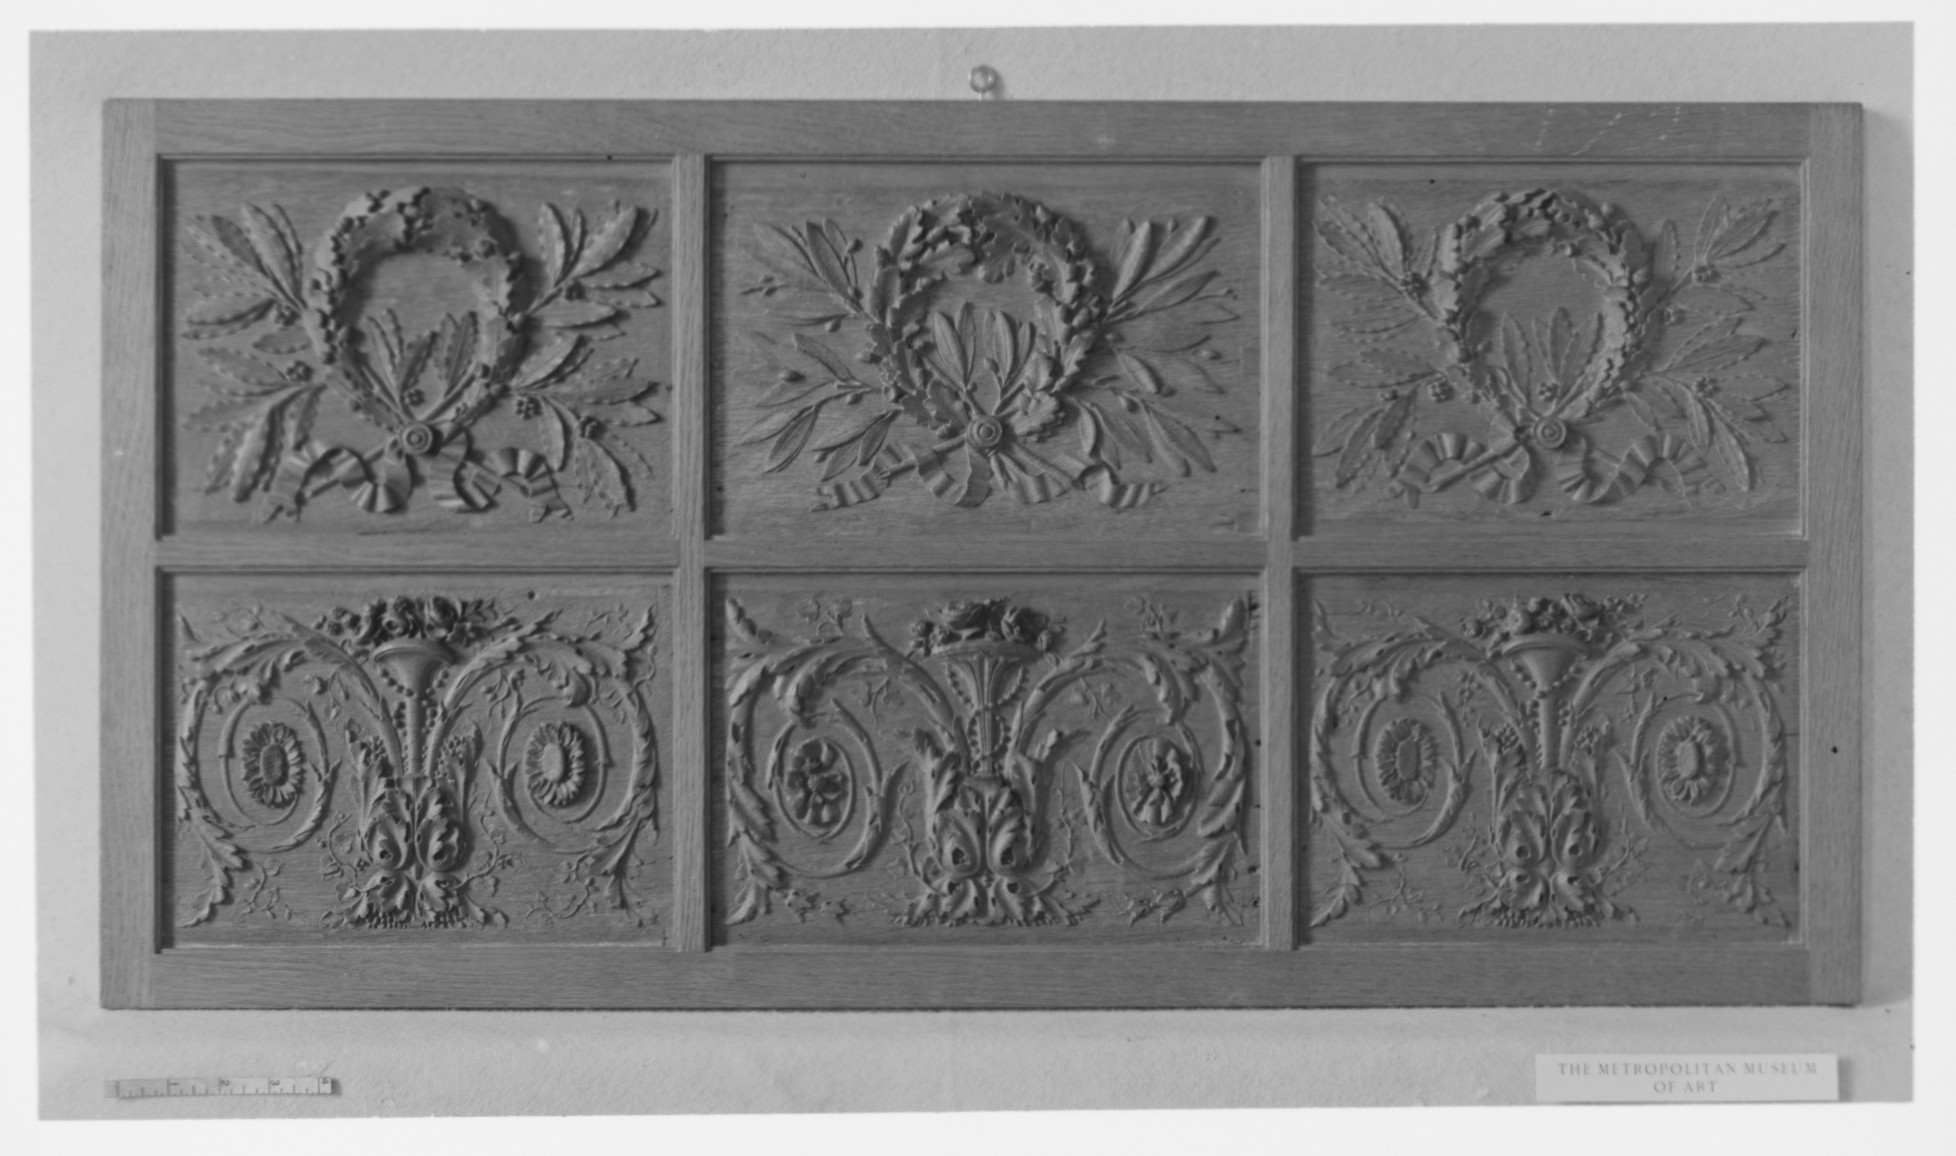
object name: panel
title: Set of six panels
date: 1701-1800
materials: wood, wax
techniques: polish